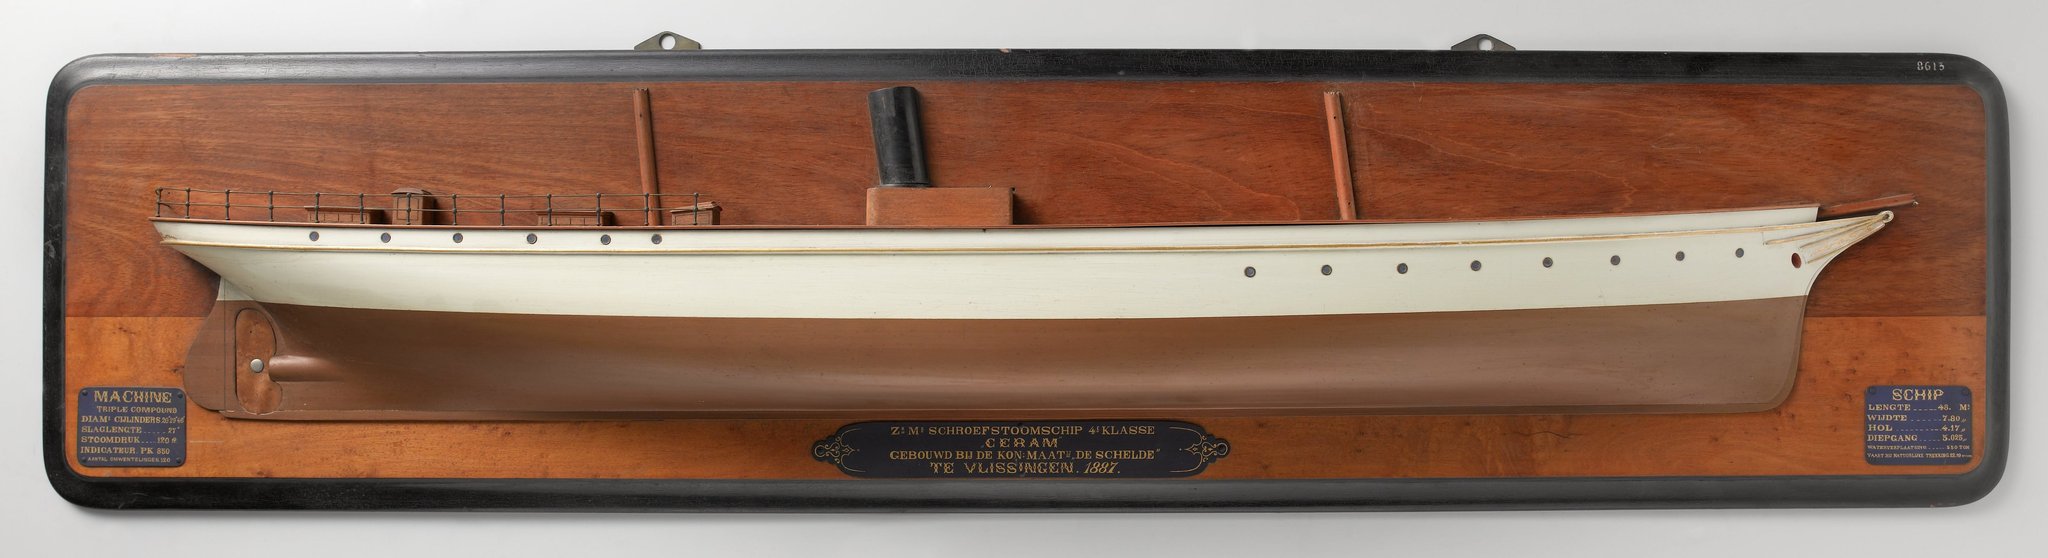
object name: builder's model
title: Half Model of a Screw Steamer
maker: Anonymous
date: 1887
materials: wood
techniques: polychromy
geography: netherlands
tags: flushing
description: Voorschip met voorsteven gebogen. Scheg S-vormig. Galjoen aangegeven, twee slooiknieen en gesloten verschansing. Kluigat in het verlengde van kamhout. Zwaanshals met krul en boegspriet. Rond achterschip. Plat wulf en schuinaflopend. Achtersteven gebogen en naar achteren hellend. Schroefas steekt ver uit in schroefraam. Koninkrijkswapen op het hek. Model heeft een recht roer met ovaal blad. het onderwaterschip heeft een vrij platte bodem. Ronde kimmen naar voeren en achteren scherper wordend. Weinig zeeg. Er zijn twee dekken aangegeven door patrijspoorten. Op de opbouw midscheeps een schoorsteen. Op het achterschip diverse luiken en een roef. De huid is glad en gesloten. In het voorschip op het onderdek acht ronde poortjes. Op het halfdek in boord zes ronde poortjes met een diameter van 7 mm. Op het halfdek een railing met dertien scepters. Het tuig bestaat uit twee masten en een boegspriet. Onder het model drie plaatjes met opschrift in goudkleurige verf.